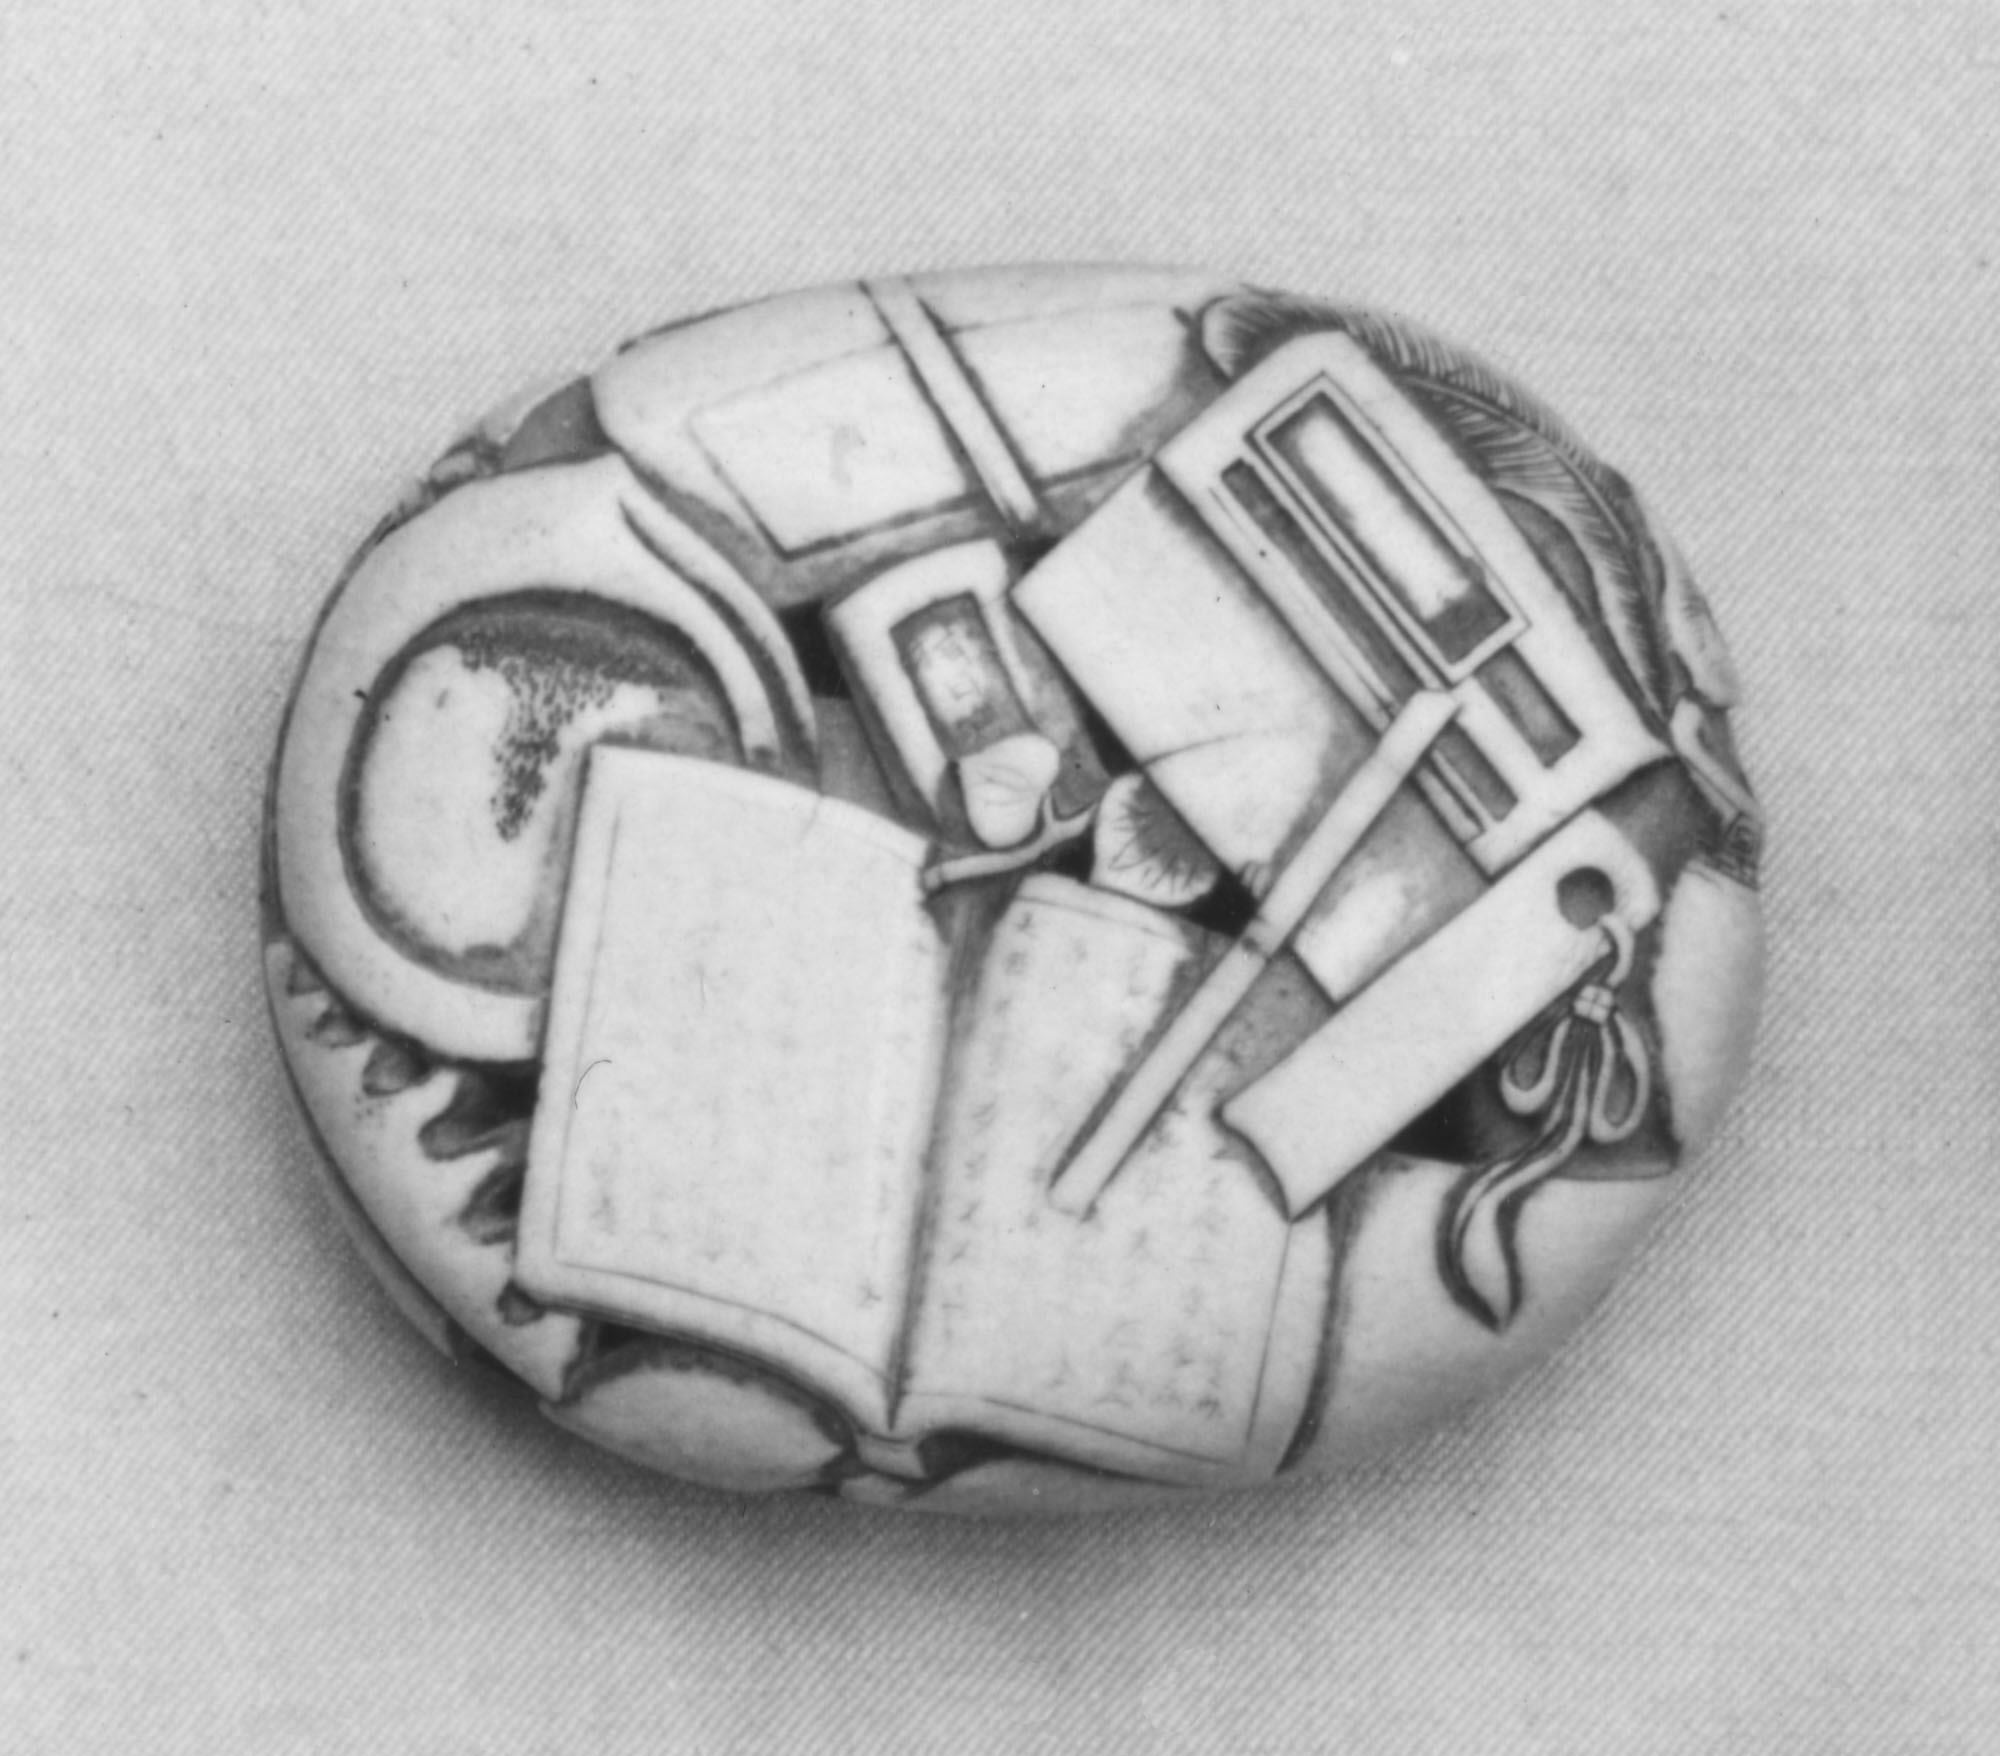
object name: netsuke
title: Writing Utensils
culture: japanese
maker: ryūsen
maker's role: artist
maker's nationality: japanese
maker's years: 1834-1866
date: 1834-1866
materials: ivory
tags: writing implements